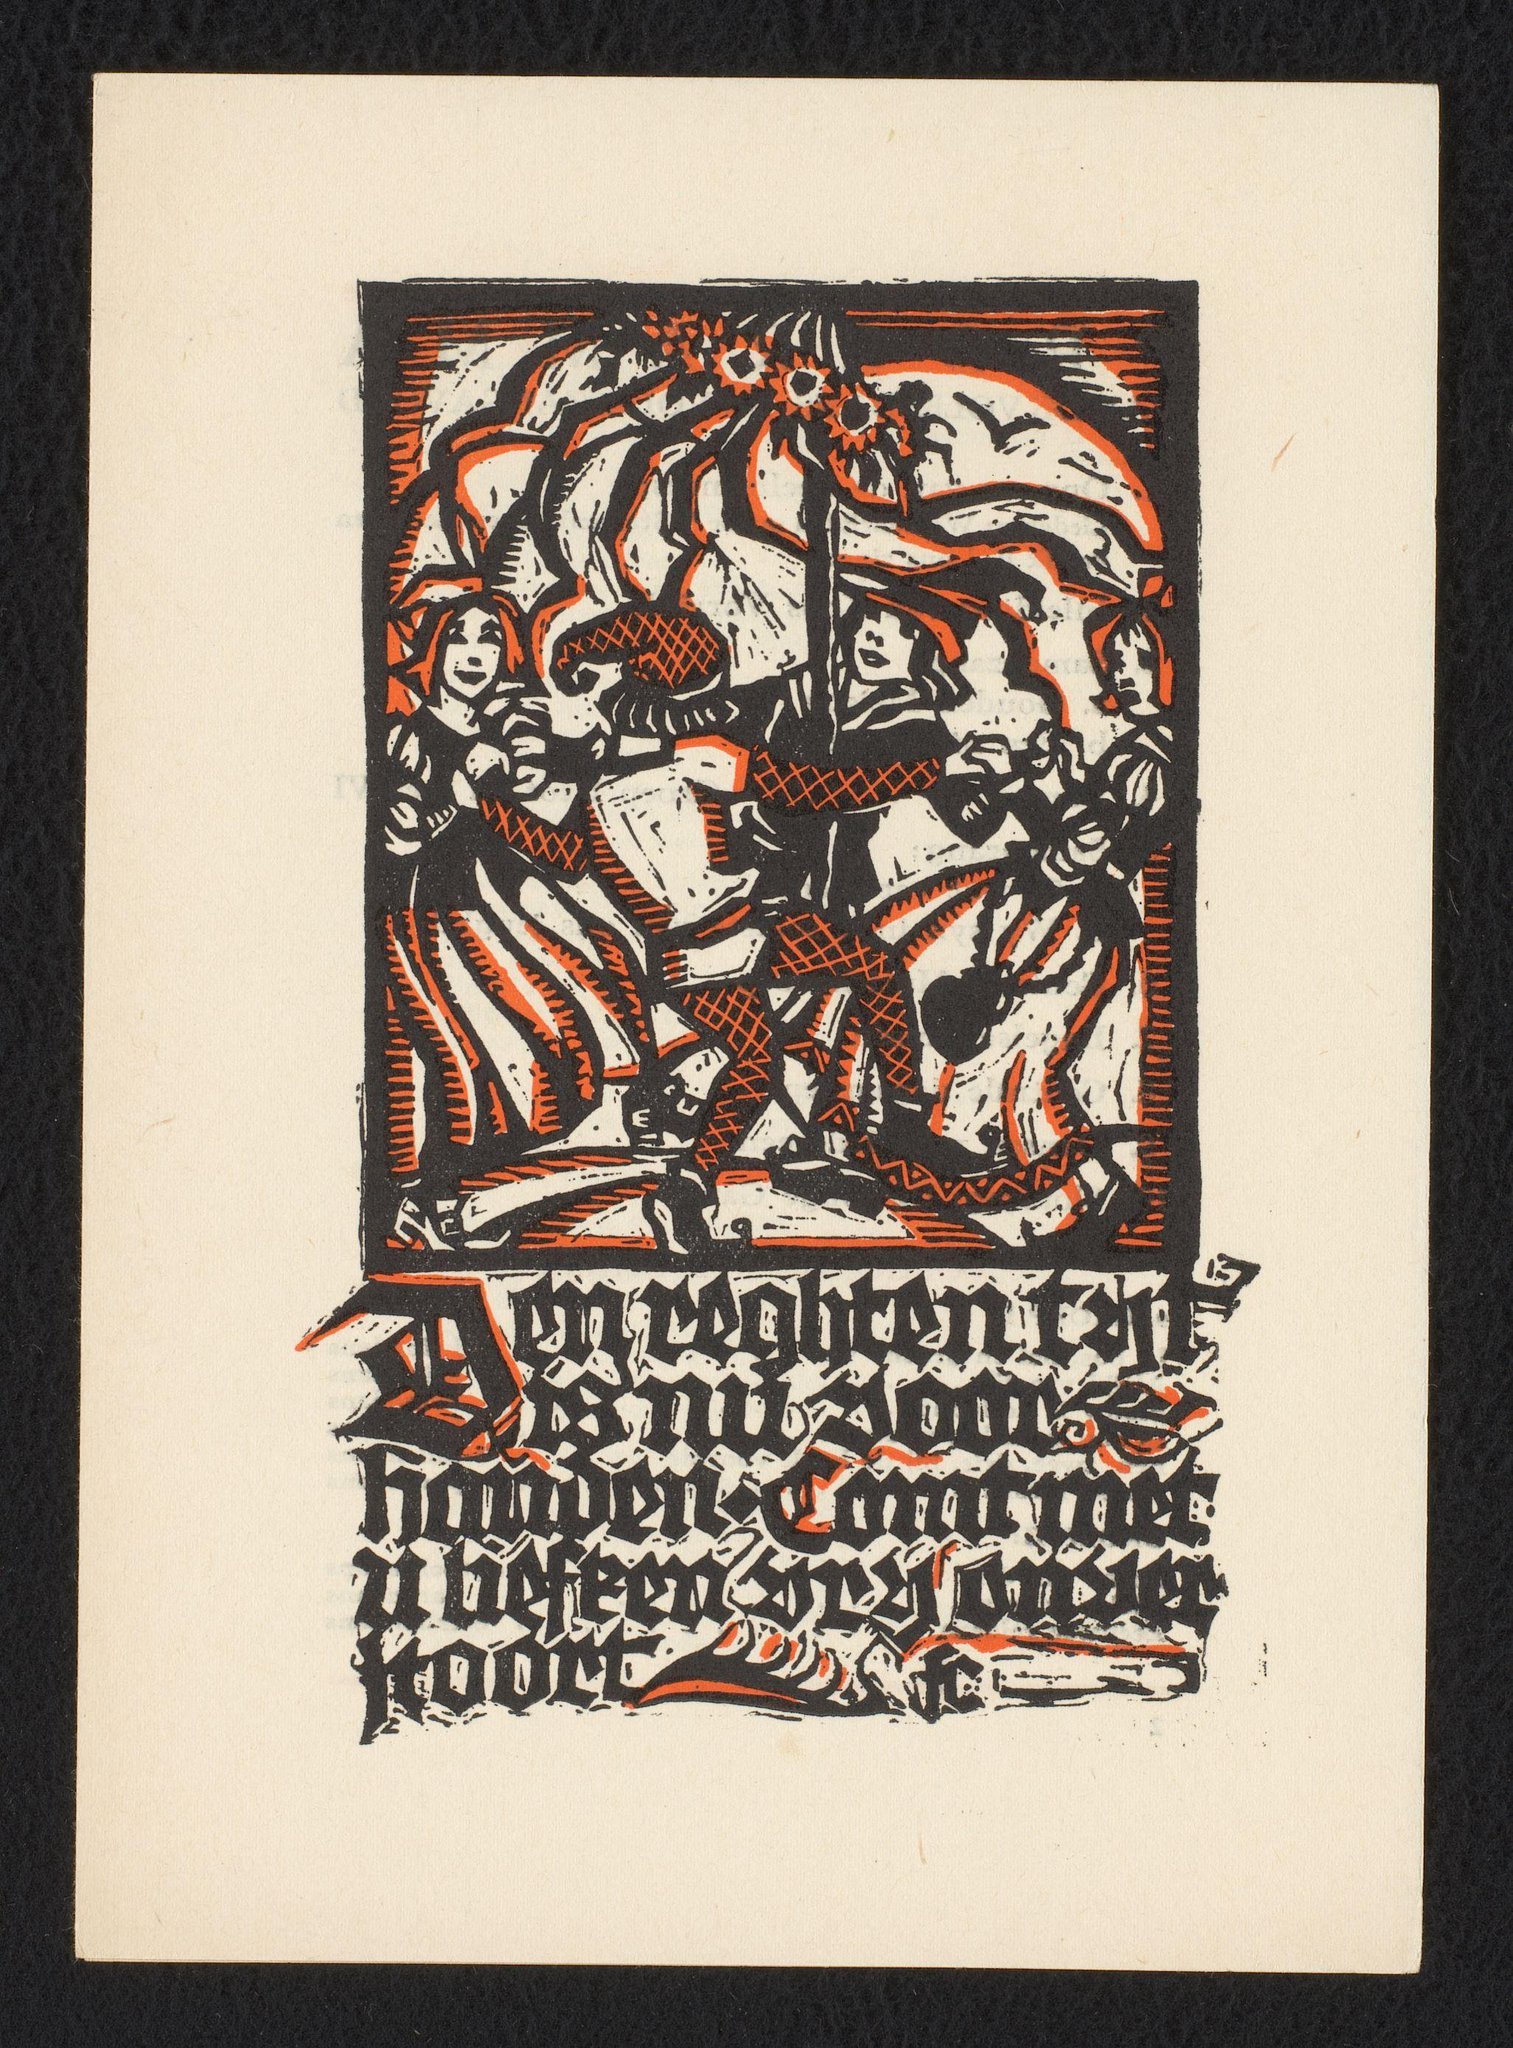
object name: print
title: Programma van de volksdans- en volkszangavond, 'A.J.C. - afdeling Amsterdam'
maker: fré cohen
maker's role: draughtsman, print maker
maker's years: 1903-1943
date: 1930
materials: paper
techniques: letterpress printing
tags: folk dancing (men and women together), dancing around the maypole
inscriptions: collector's mark: Lugt 2228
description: Twee mannen en twee vrouwen dansen rond een meiboom. Daaronder de tekst: 'Den reghten tijt is nu voorhanden. Comt met u [...] vrij onverstoort'. Tweemaal gevouwen blad met binnenin het programma van de dag, de volgorde van de dansen en tekst van enkele liederen. De dag vond plaats op 3 maart 1930 in het Concertgebouw van Amsterdam.